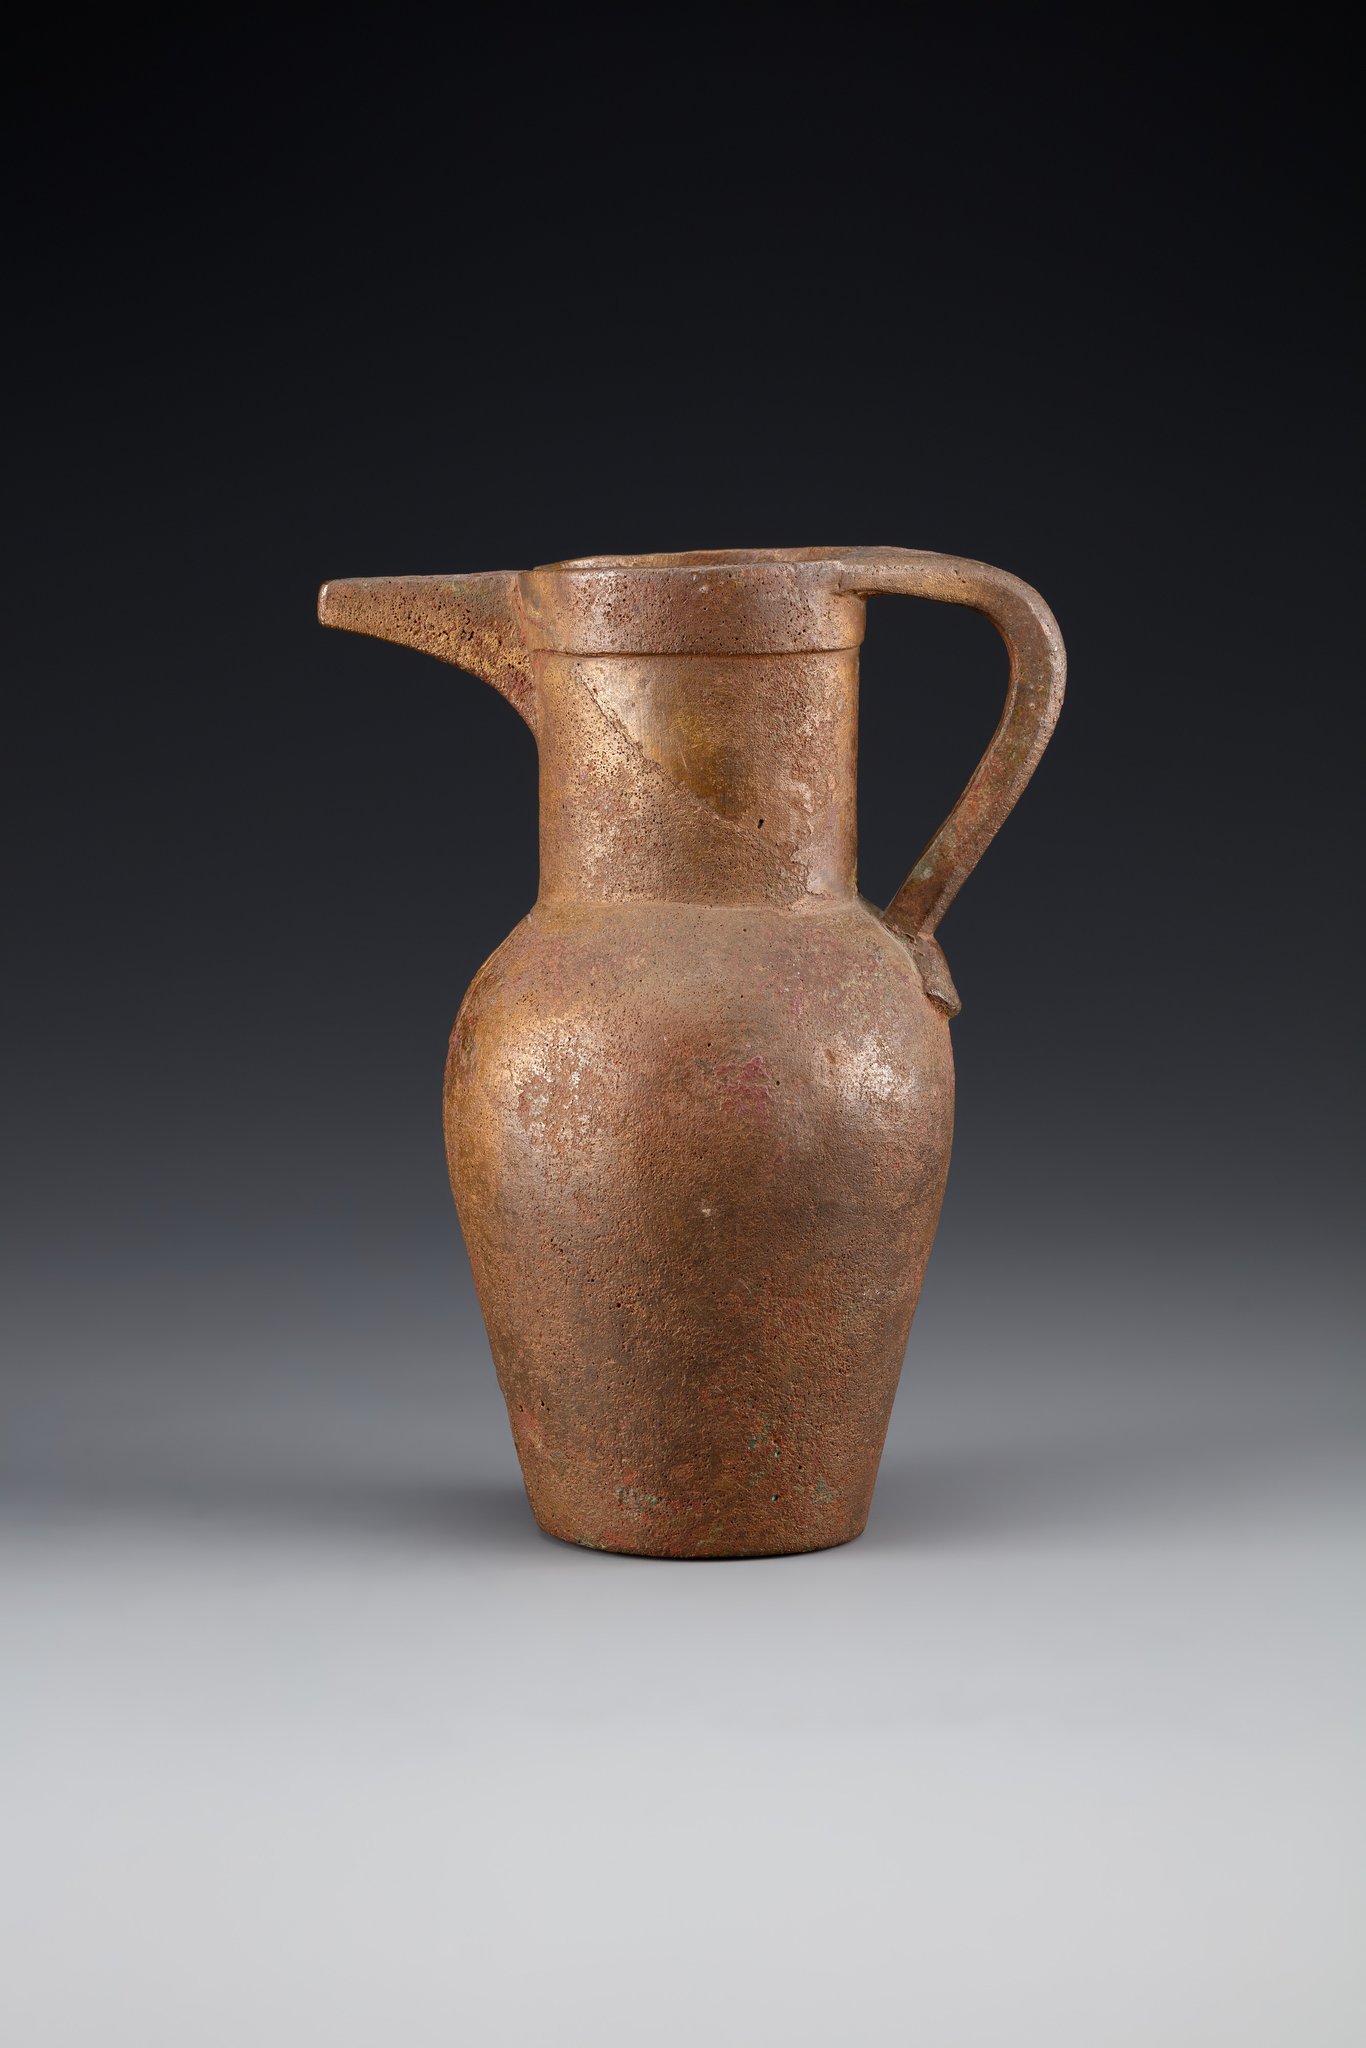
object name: jug, spouted, amun re lord of valor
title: Spouted jug inscribed for "Amun-Re Lord of Valor"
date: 1550-1070 BCE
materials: bronze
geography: memphite region